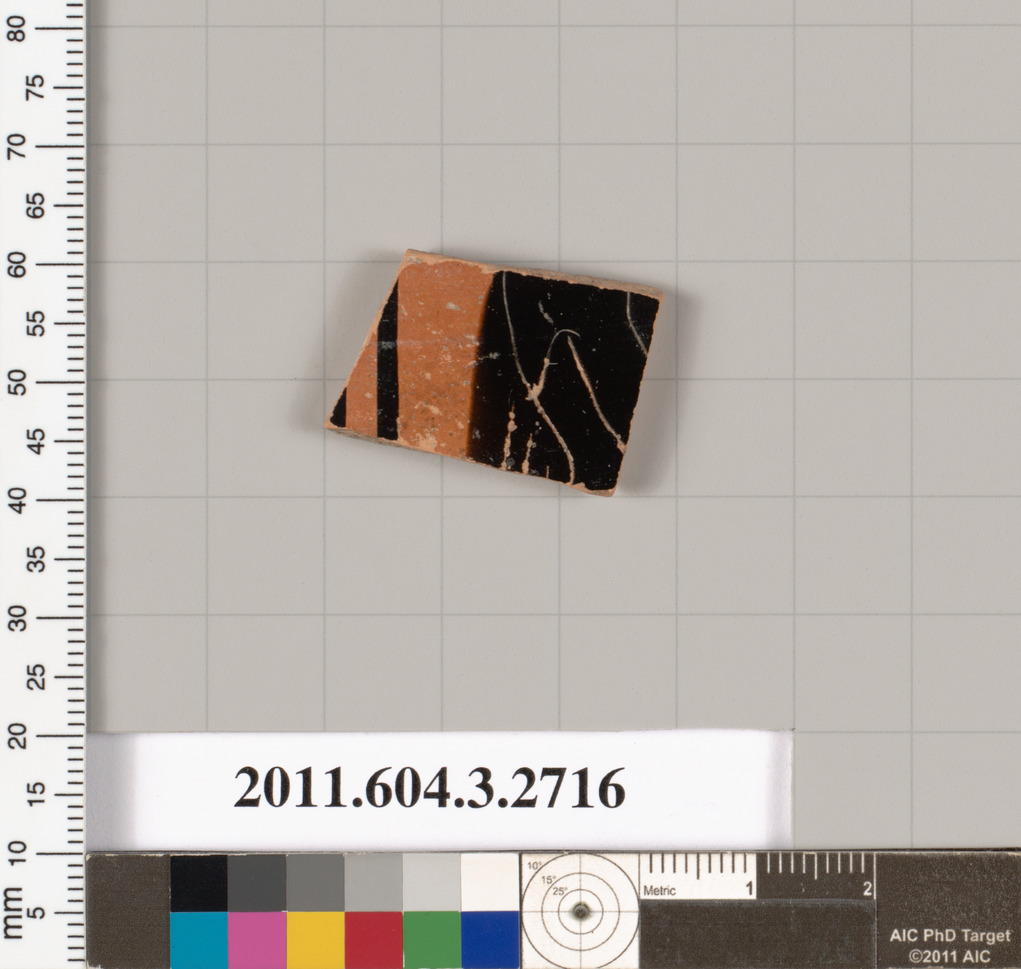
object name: oinochoe or olpe fragment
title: Terracotta fragment of an oinochoe (jug) or olpe (jug)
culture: greek, attic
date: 534-468 BCE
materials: terracotta